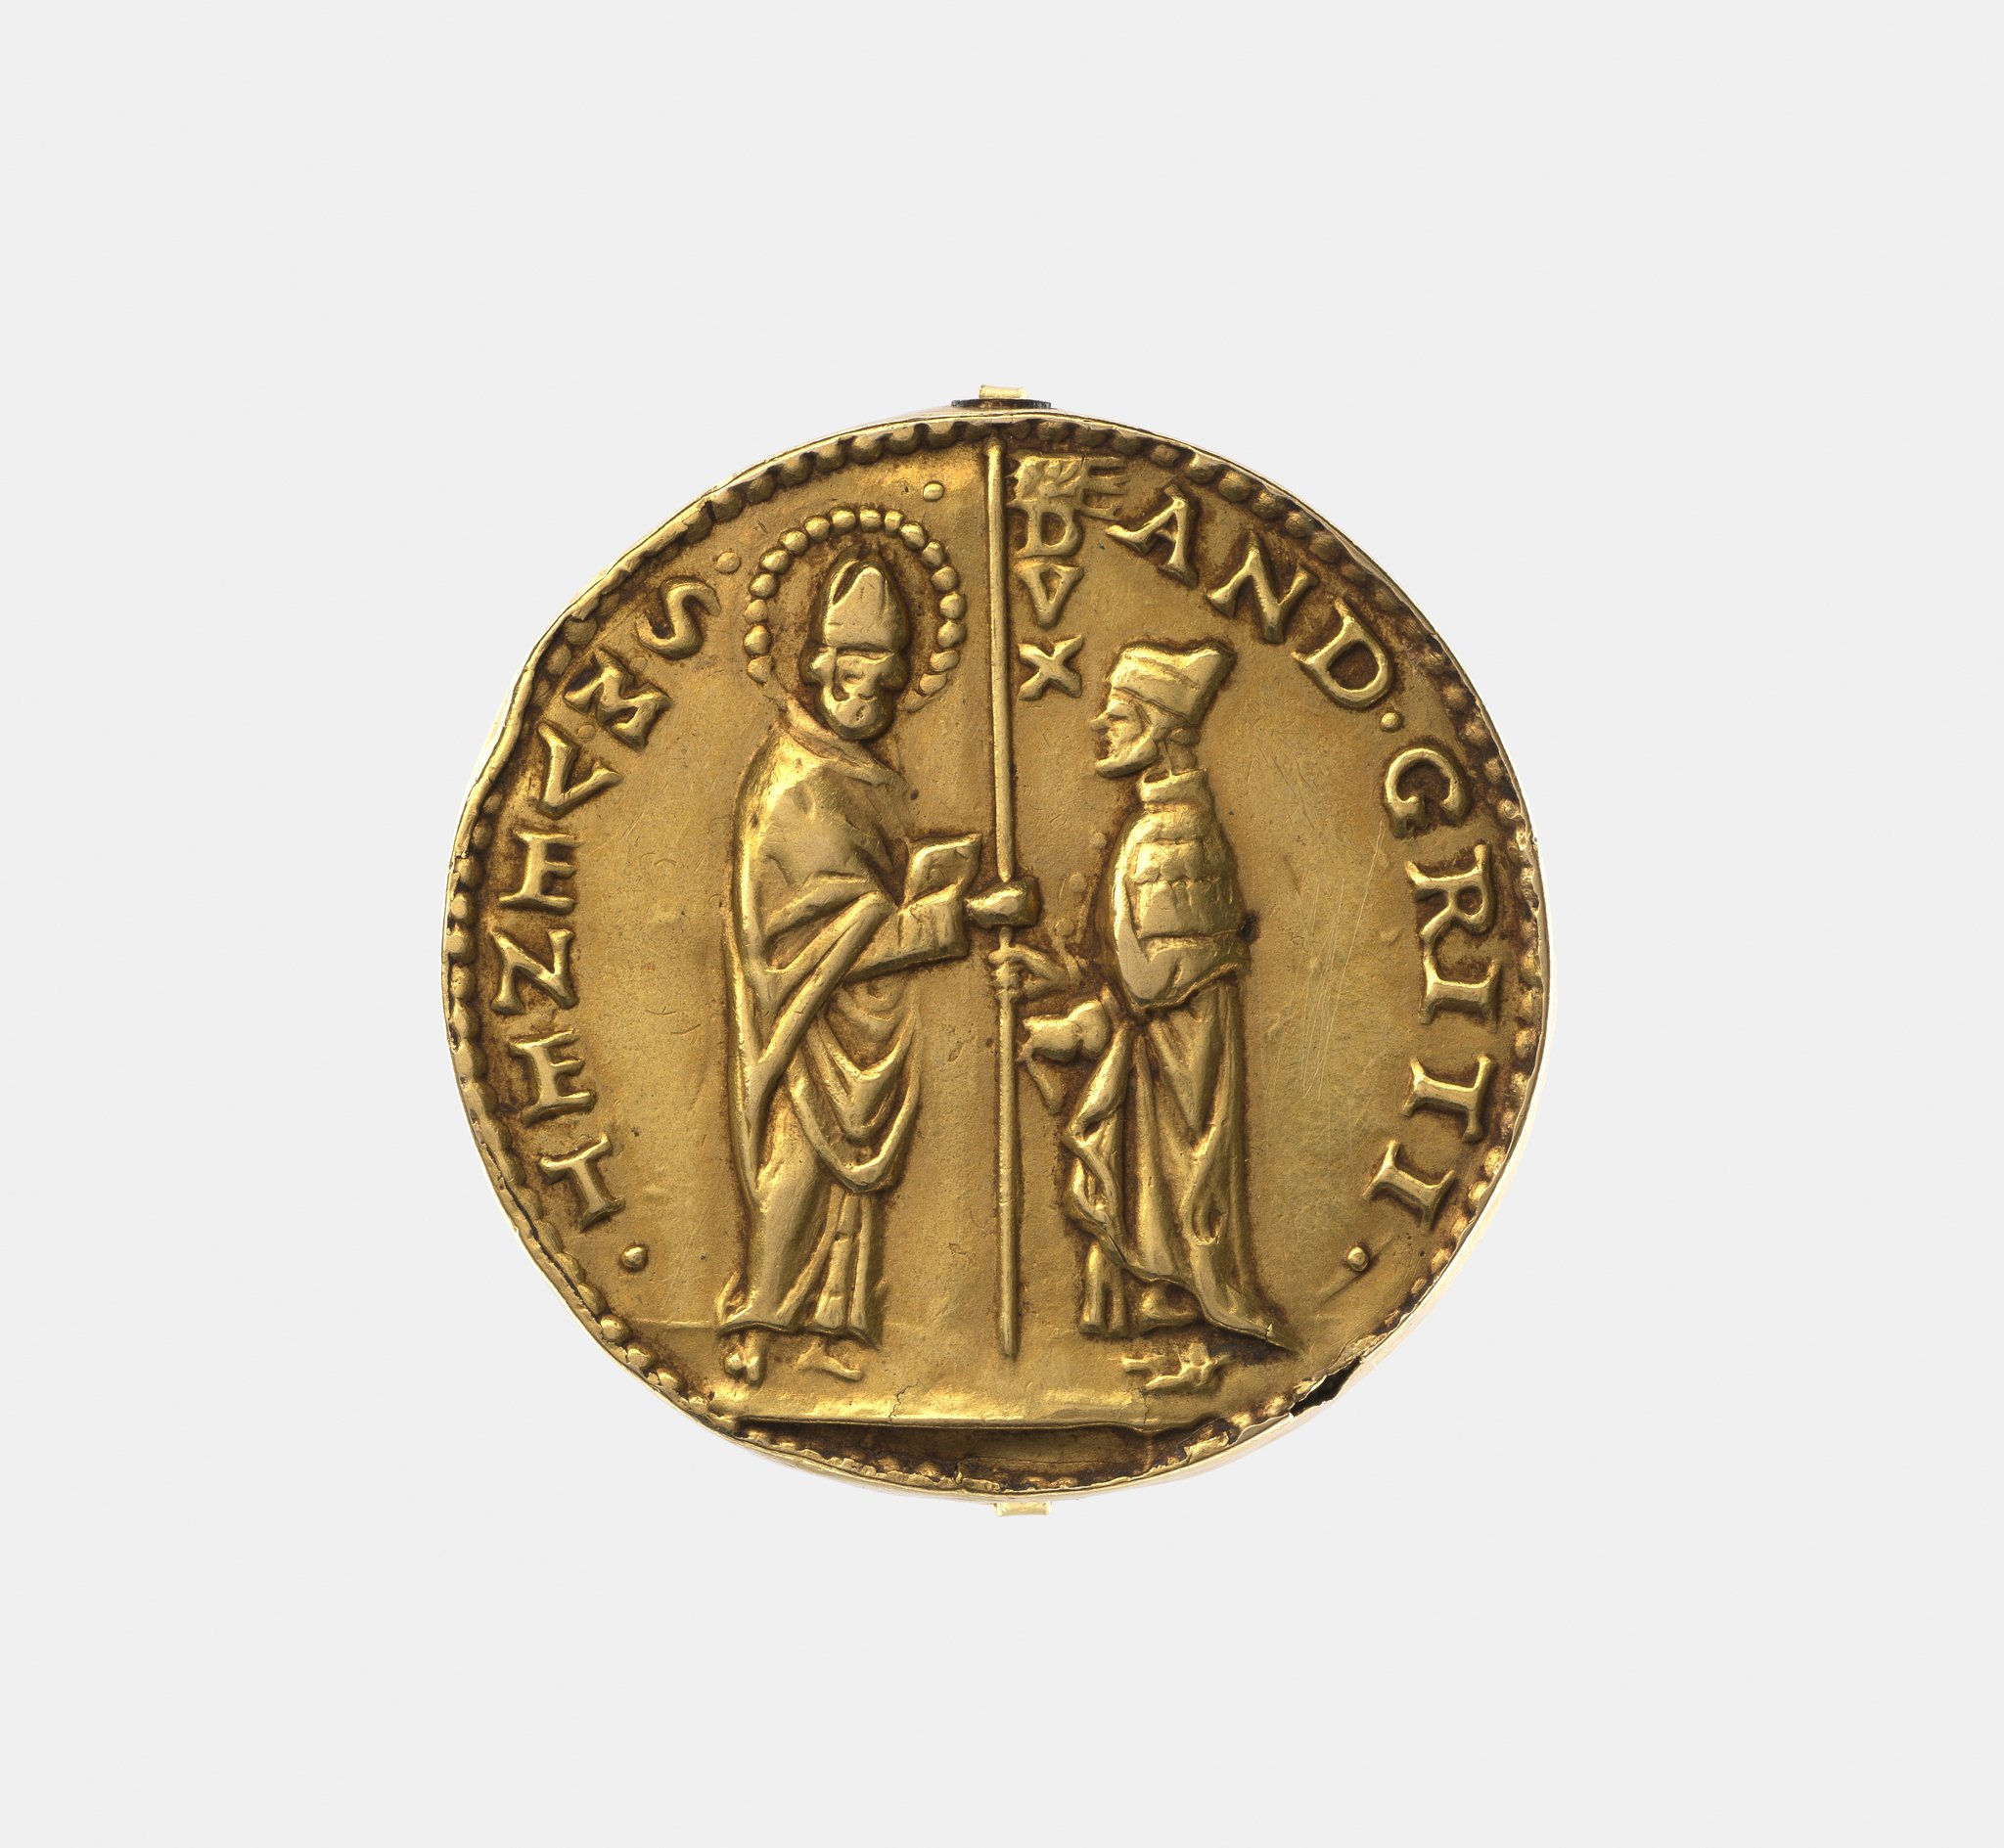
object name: seal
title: Andrea Gritti, Doge of Venice 1523-38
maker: Anonymous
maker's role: artist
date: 1500-1599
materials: gold